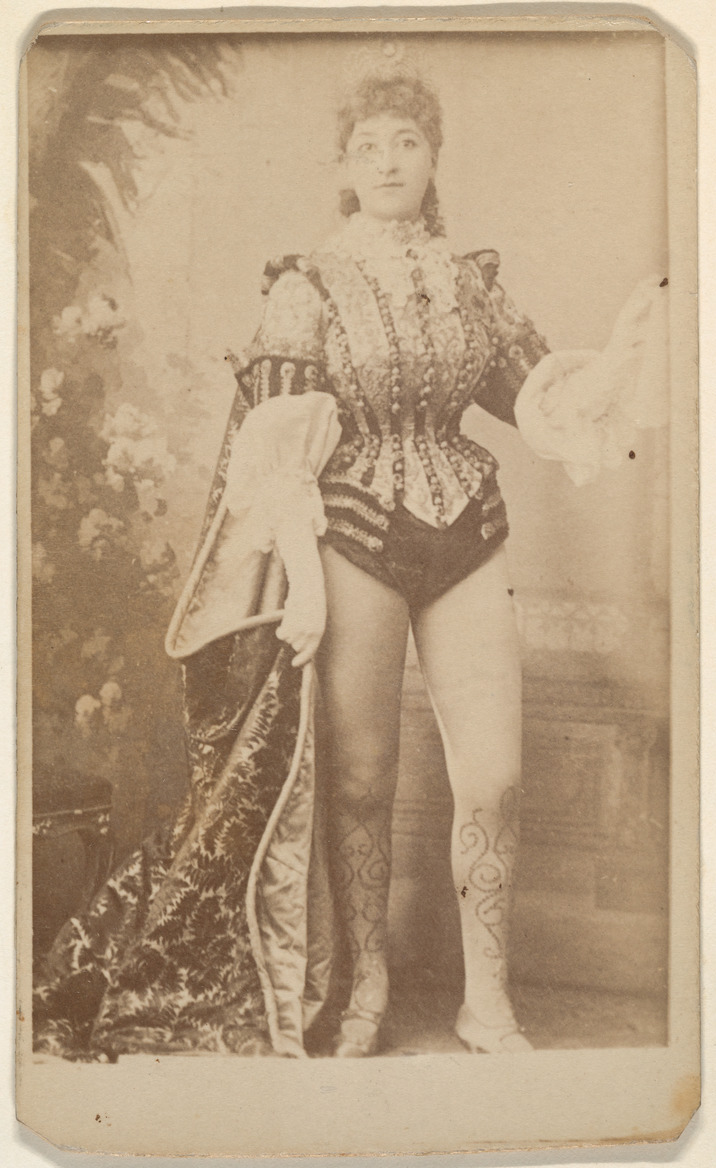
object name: photograph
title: Actress wearing military-inspired costume, from the Actresses series (N668)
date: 1888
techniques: albumen silver print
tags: portraits,women,actresses